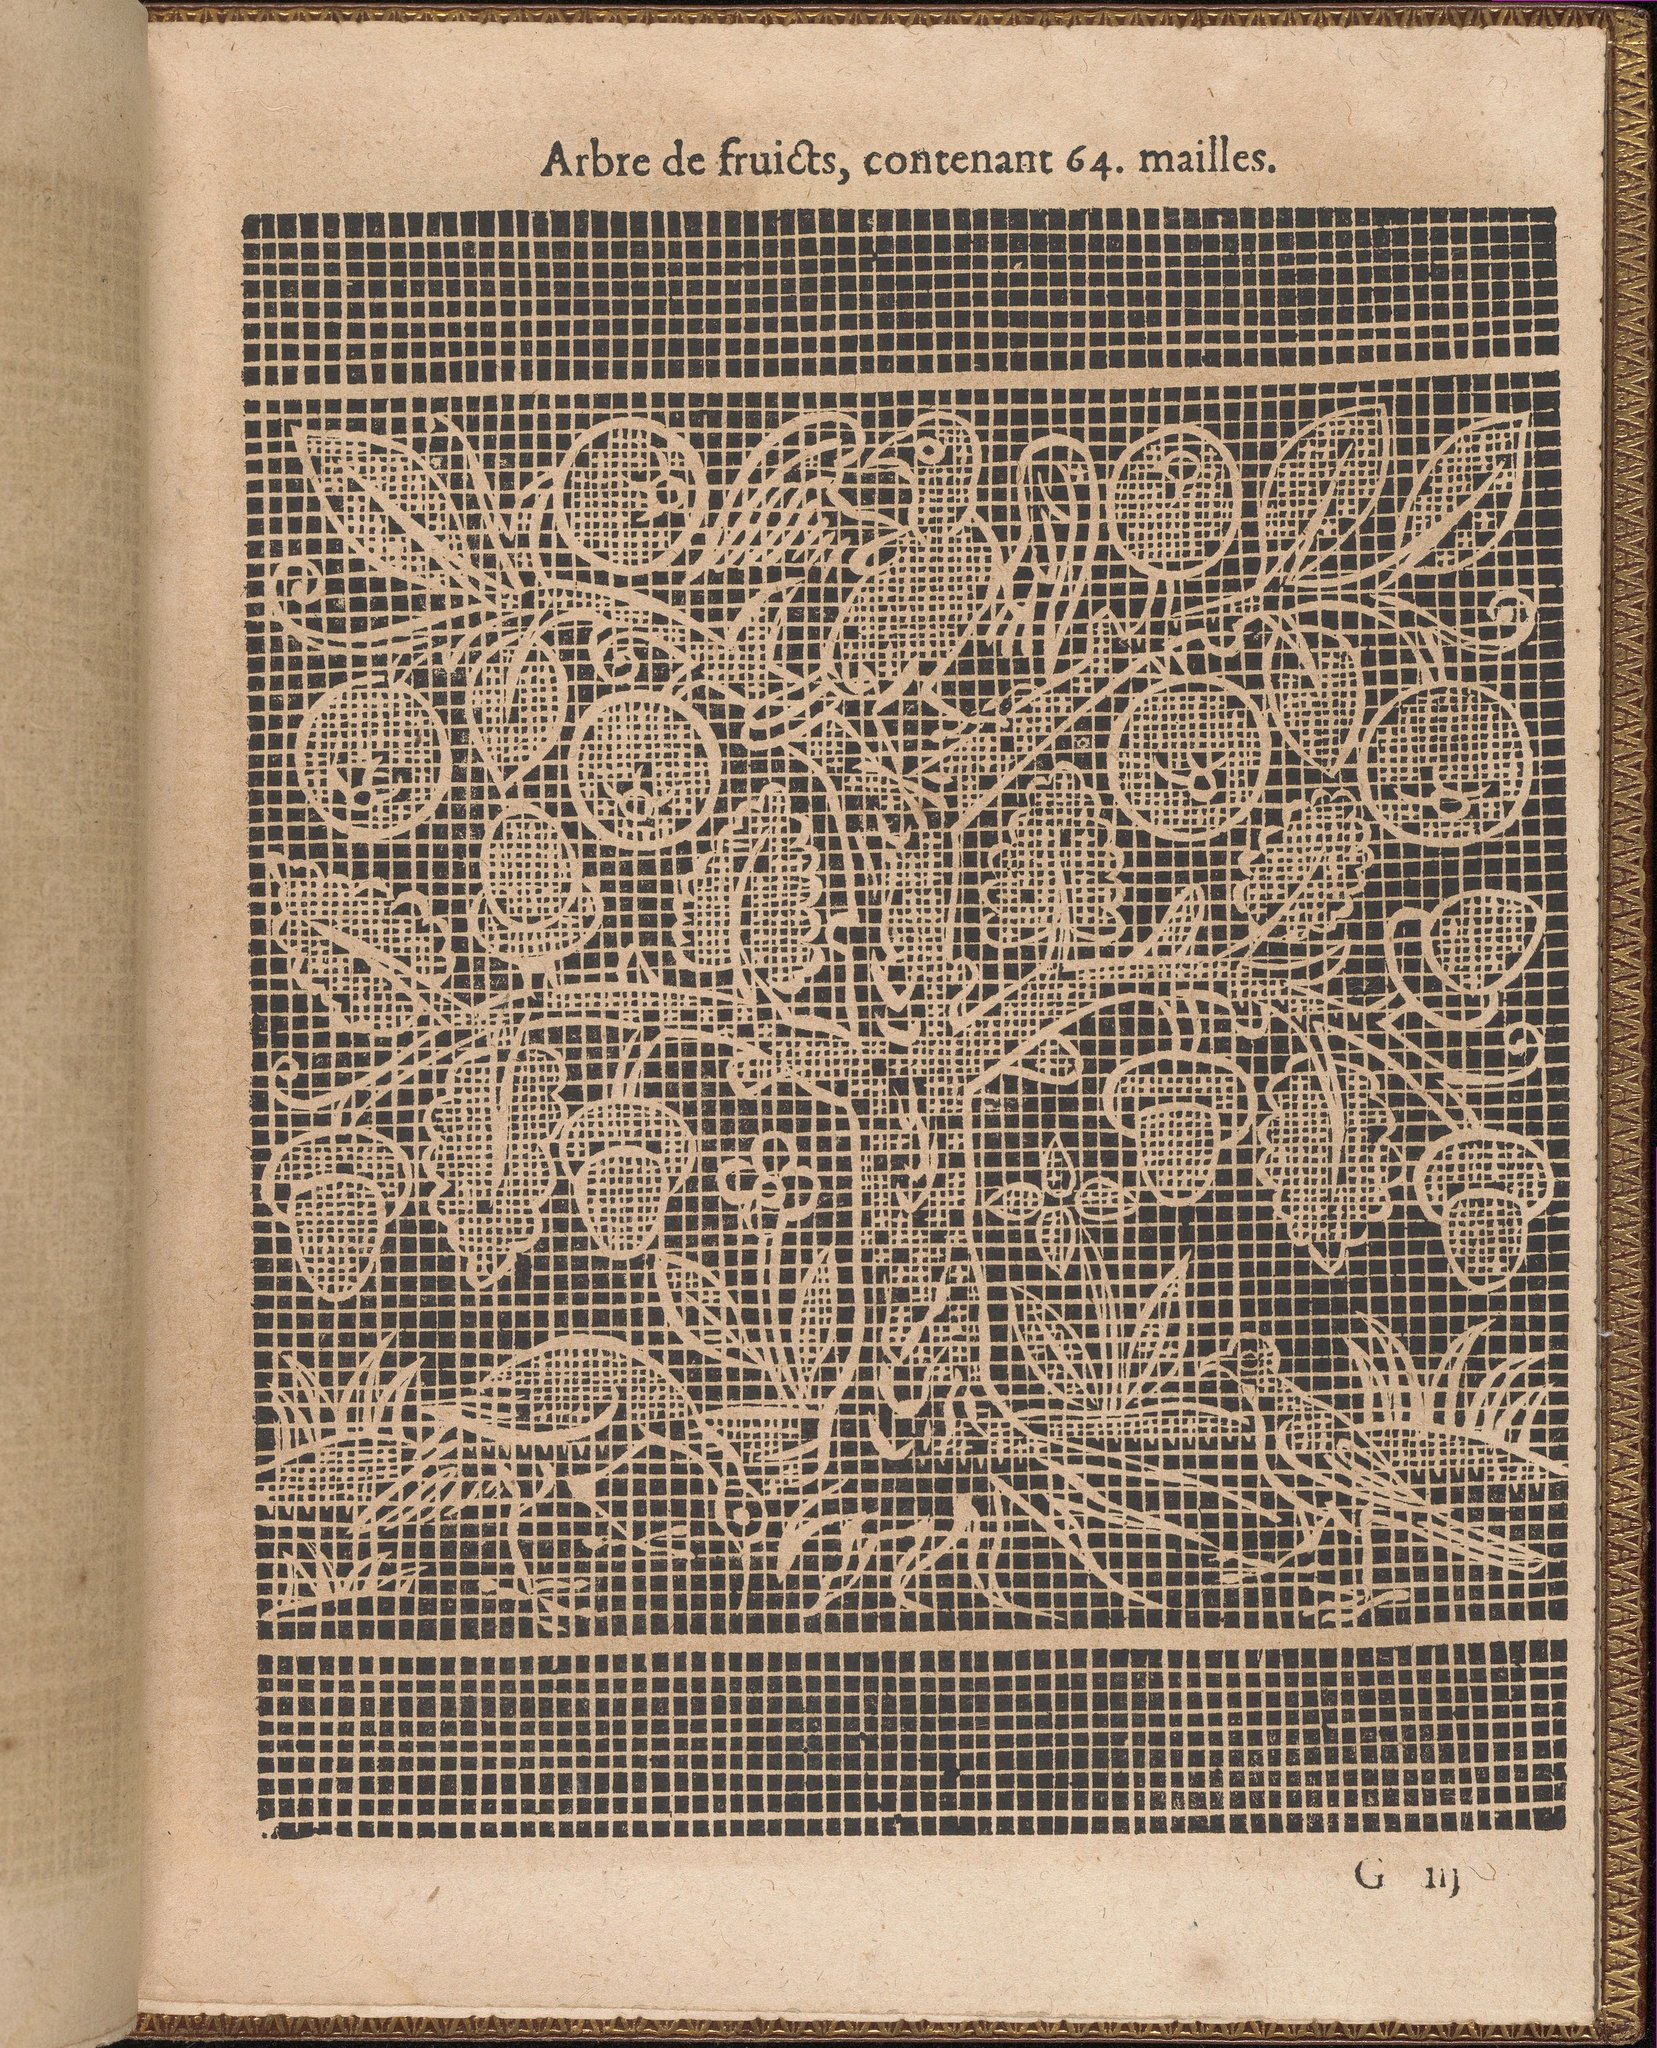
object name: book print ornament architecture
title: La Pratique de l'Aiguille, page 26 (recto)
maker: matthias mignerak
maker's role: author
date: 1605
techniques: woodcut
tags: birds